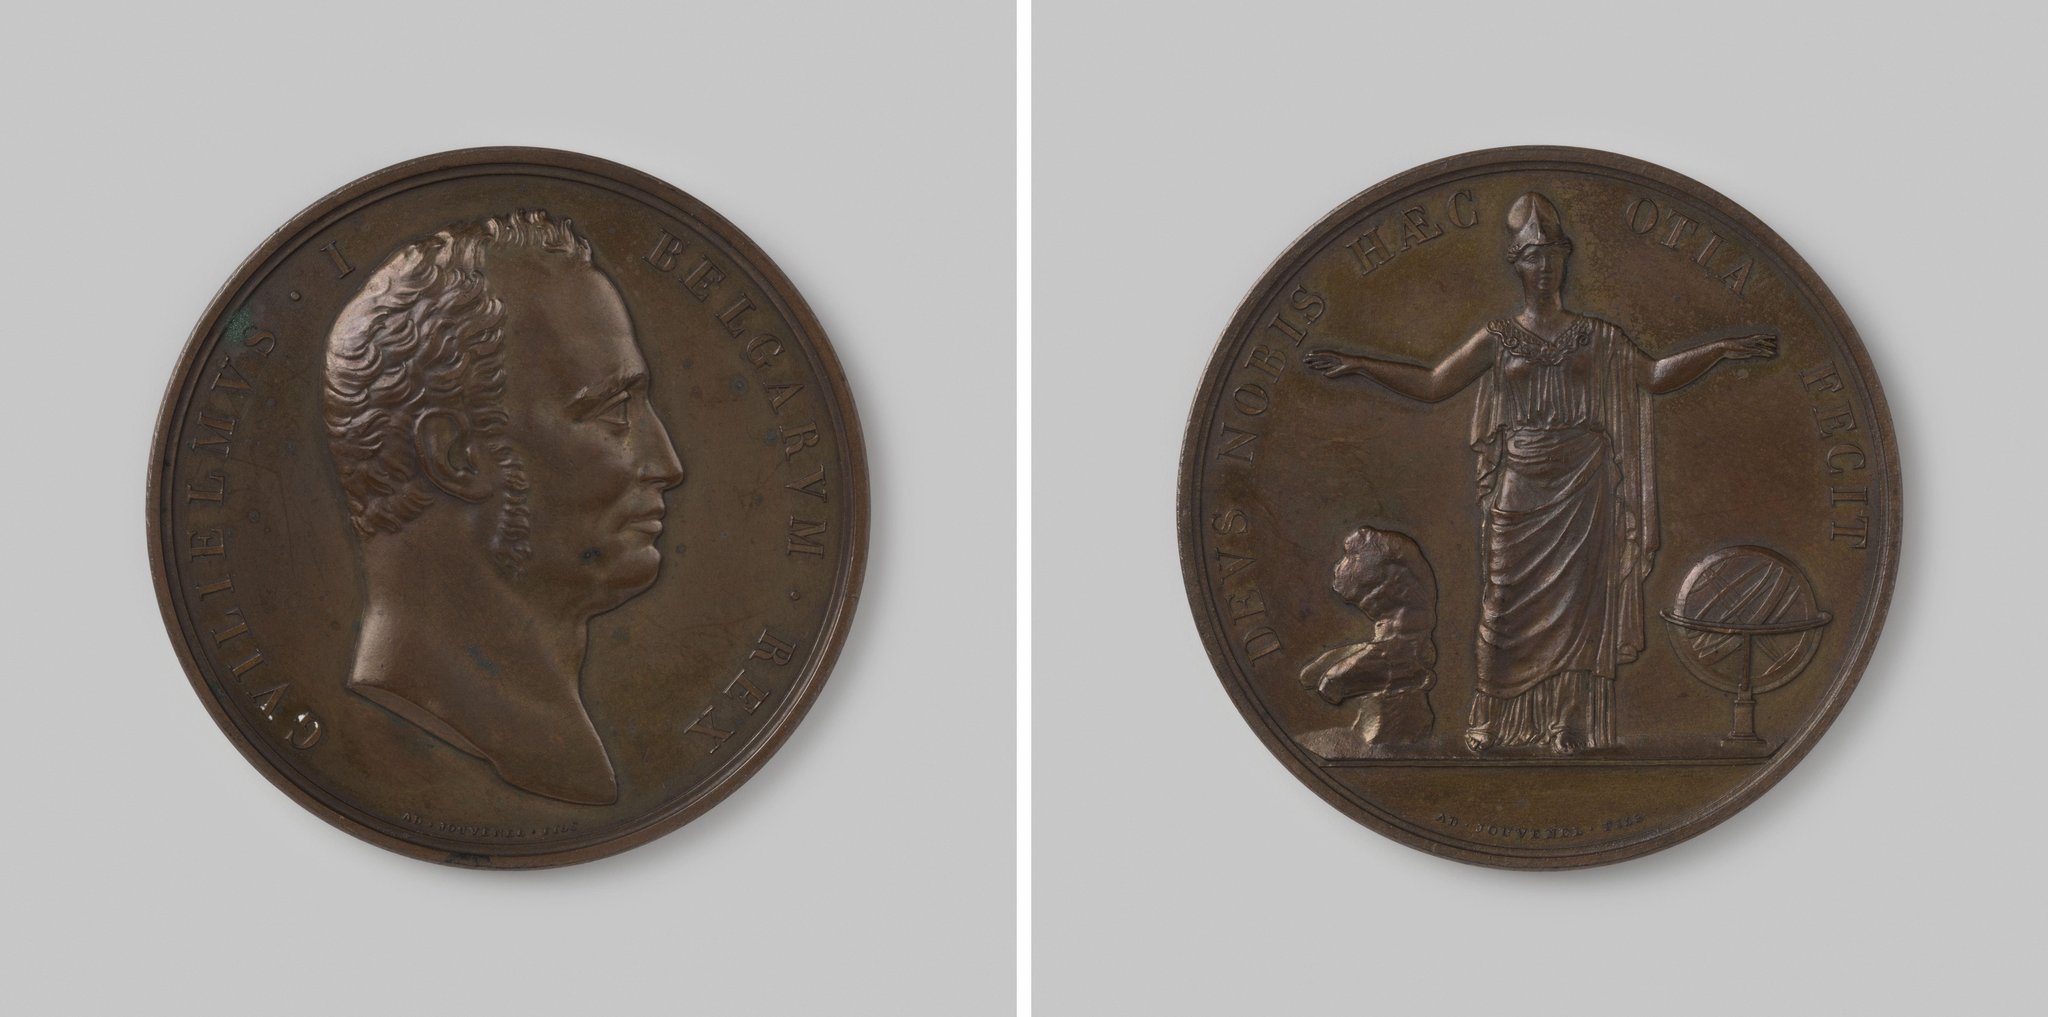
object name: history medal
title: Op de bloei van kunsten en wetenschappen 1829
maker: adolphe jouvenel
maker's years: 1798-1867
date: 1829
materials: bronze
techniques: striking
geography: brussels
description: Bronzen penning, op de voorzijde het portret van Koning Willem I naar rechts met omschrift, op de keerzijde Minerva met gespreide armen tussen een onafgewerkte torso en een hemelglobe, met omschrift.